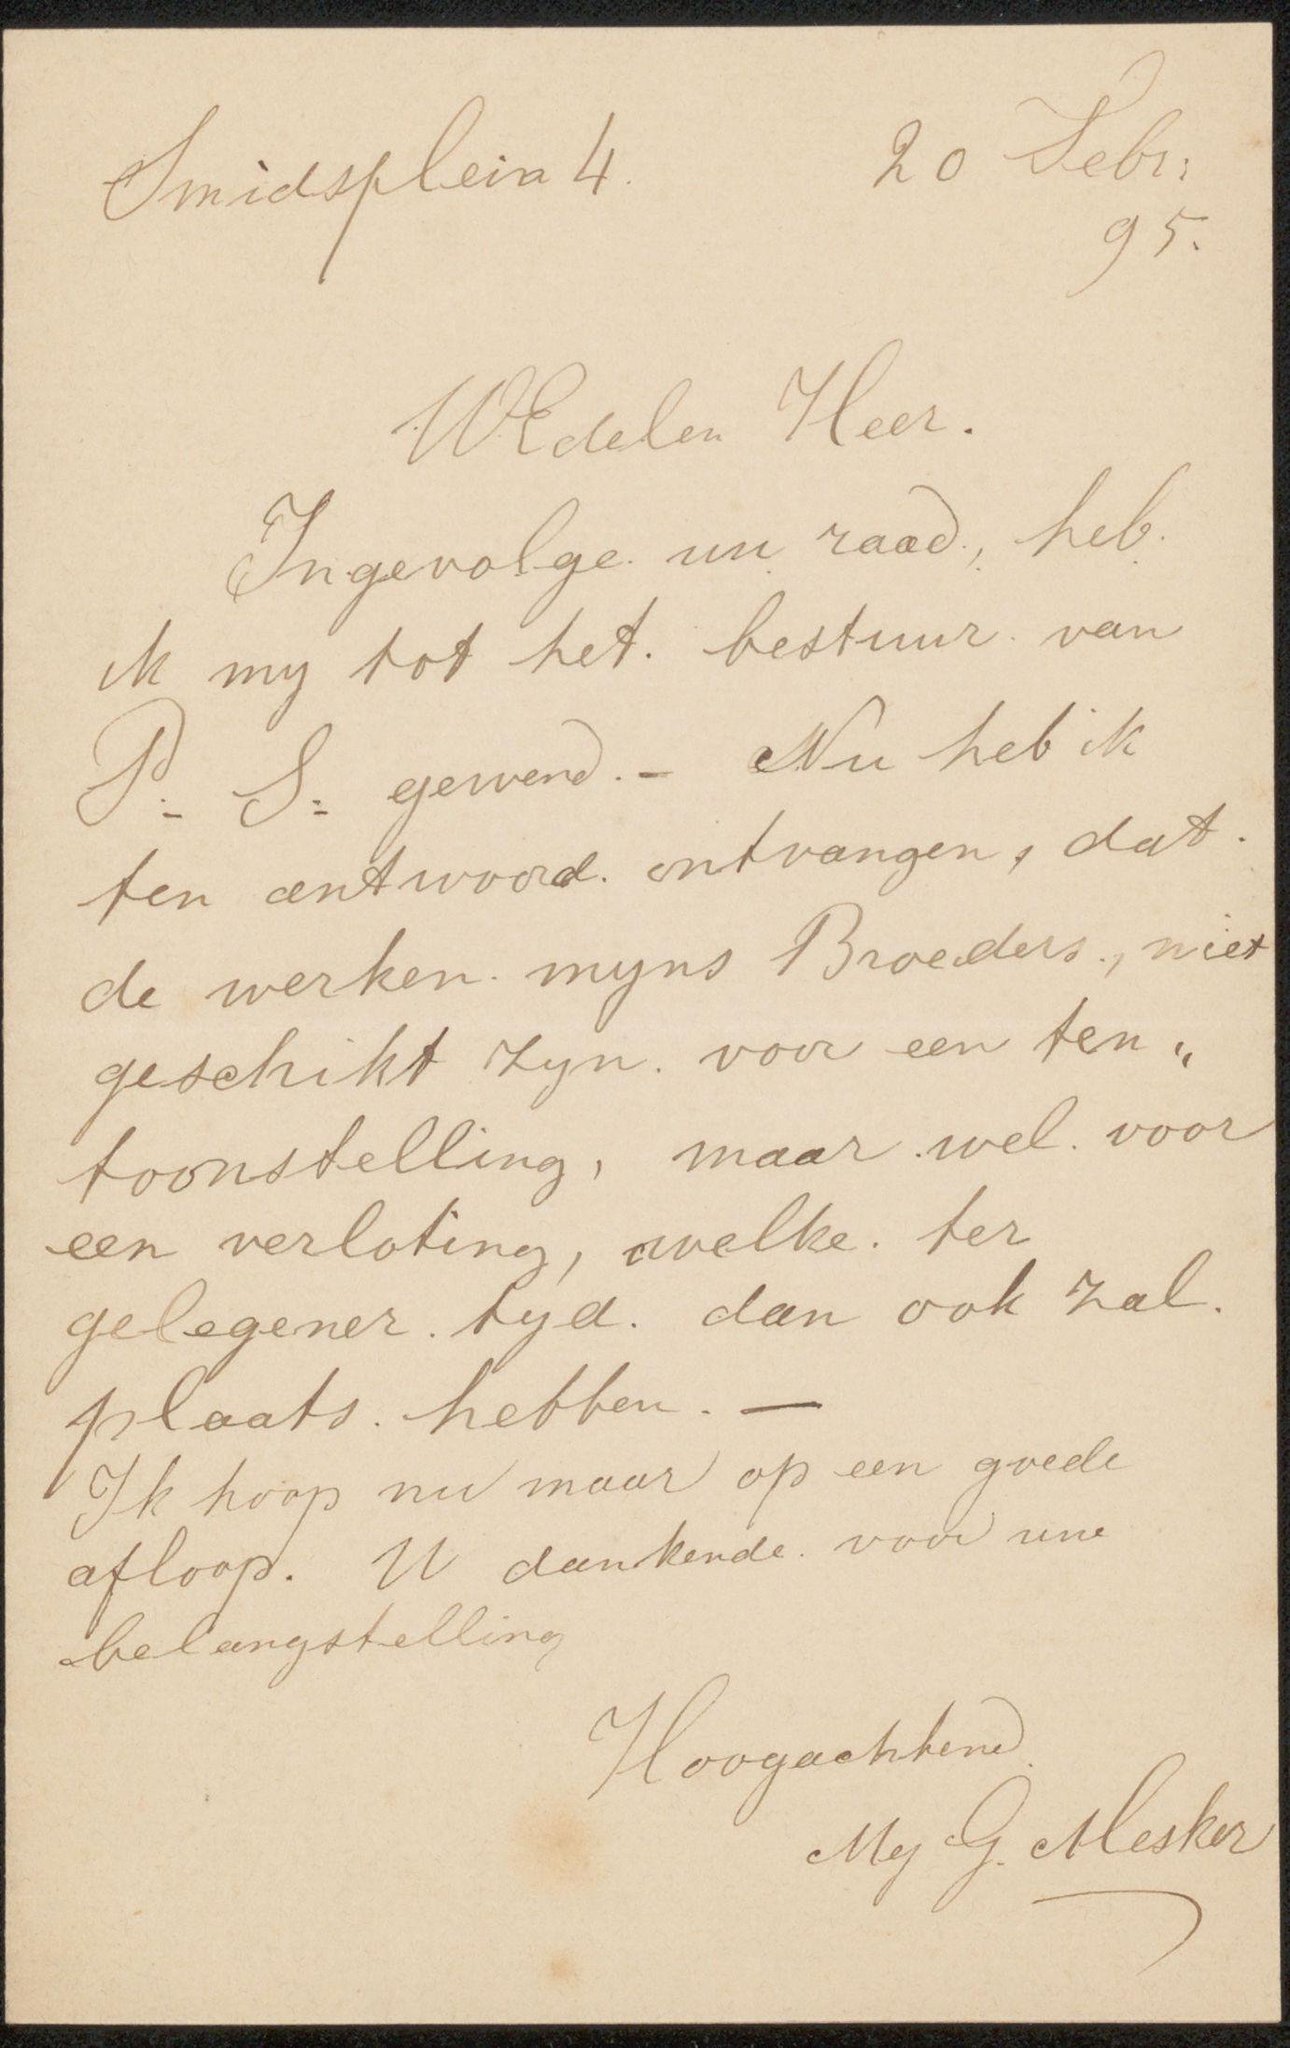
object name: letter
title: Brief aan Philip Zilcken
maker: g. mesker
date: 1895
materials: ink, paper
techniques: pen, writing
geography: the hague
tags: print maker, theo mesker, the hague, painter, draughtsman, philip zilcken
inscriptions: collector's mark: ‘RPK’